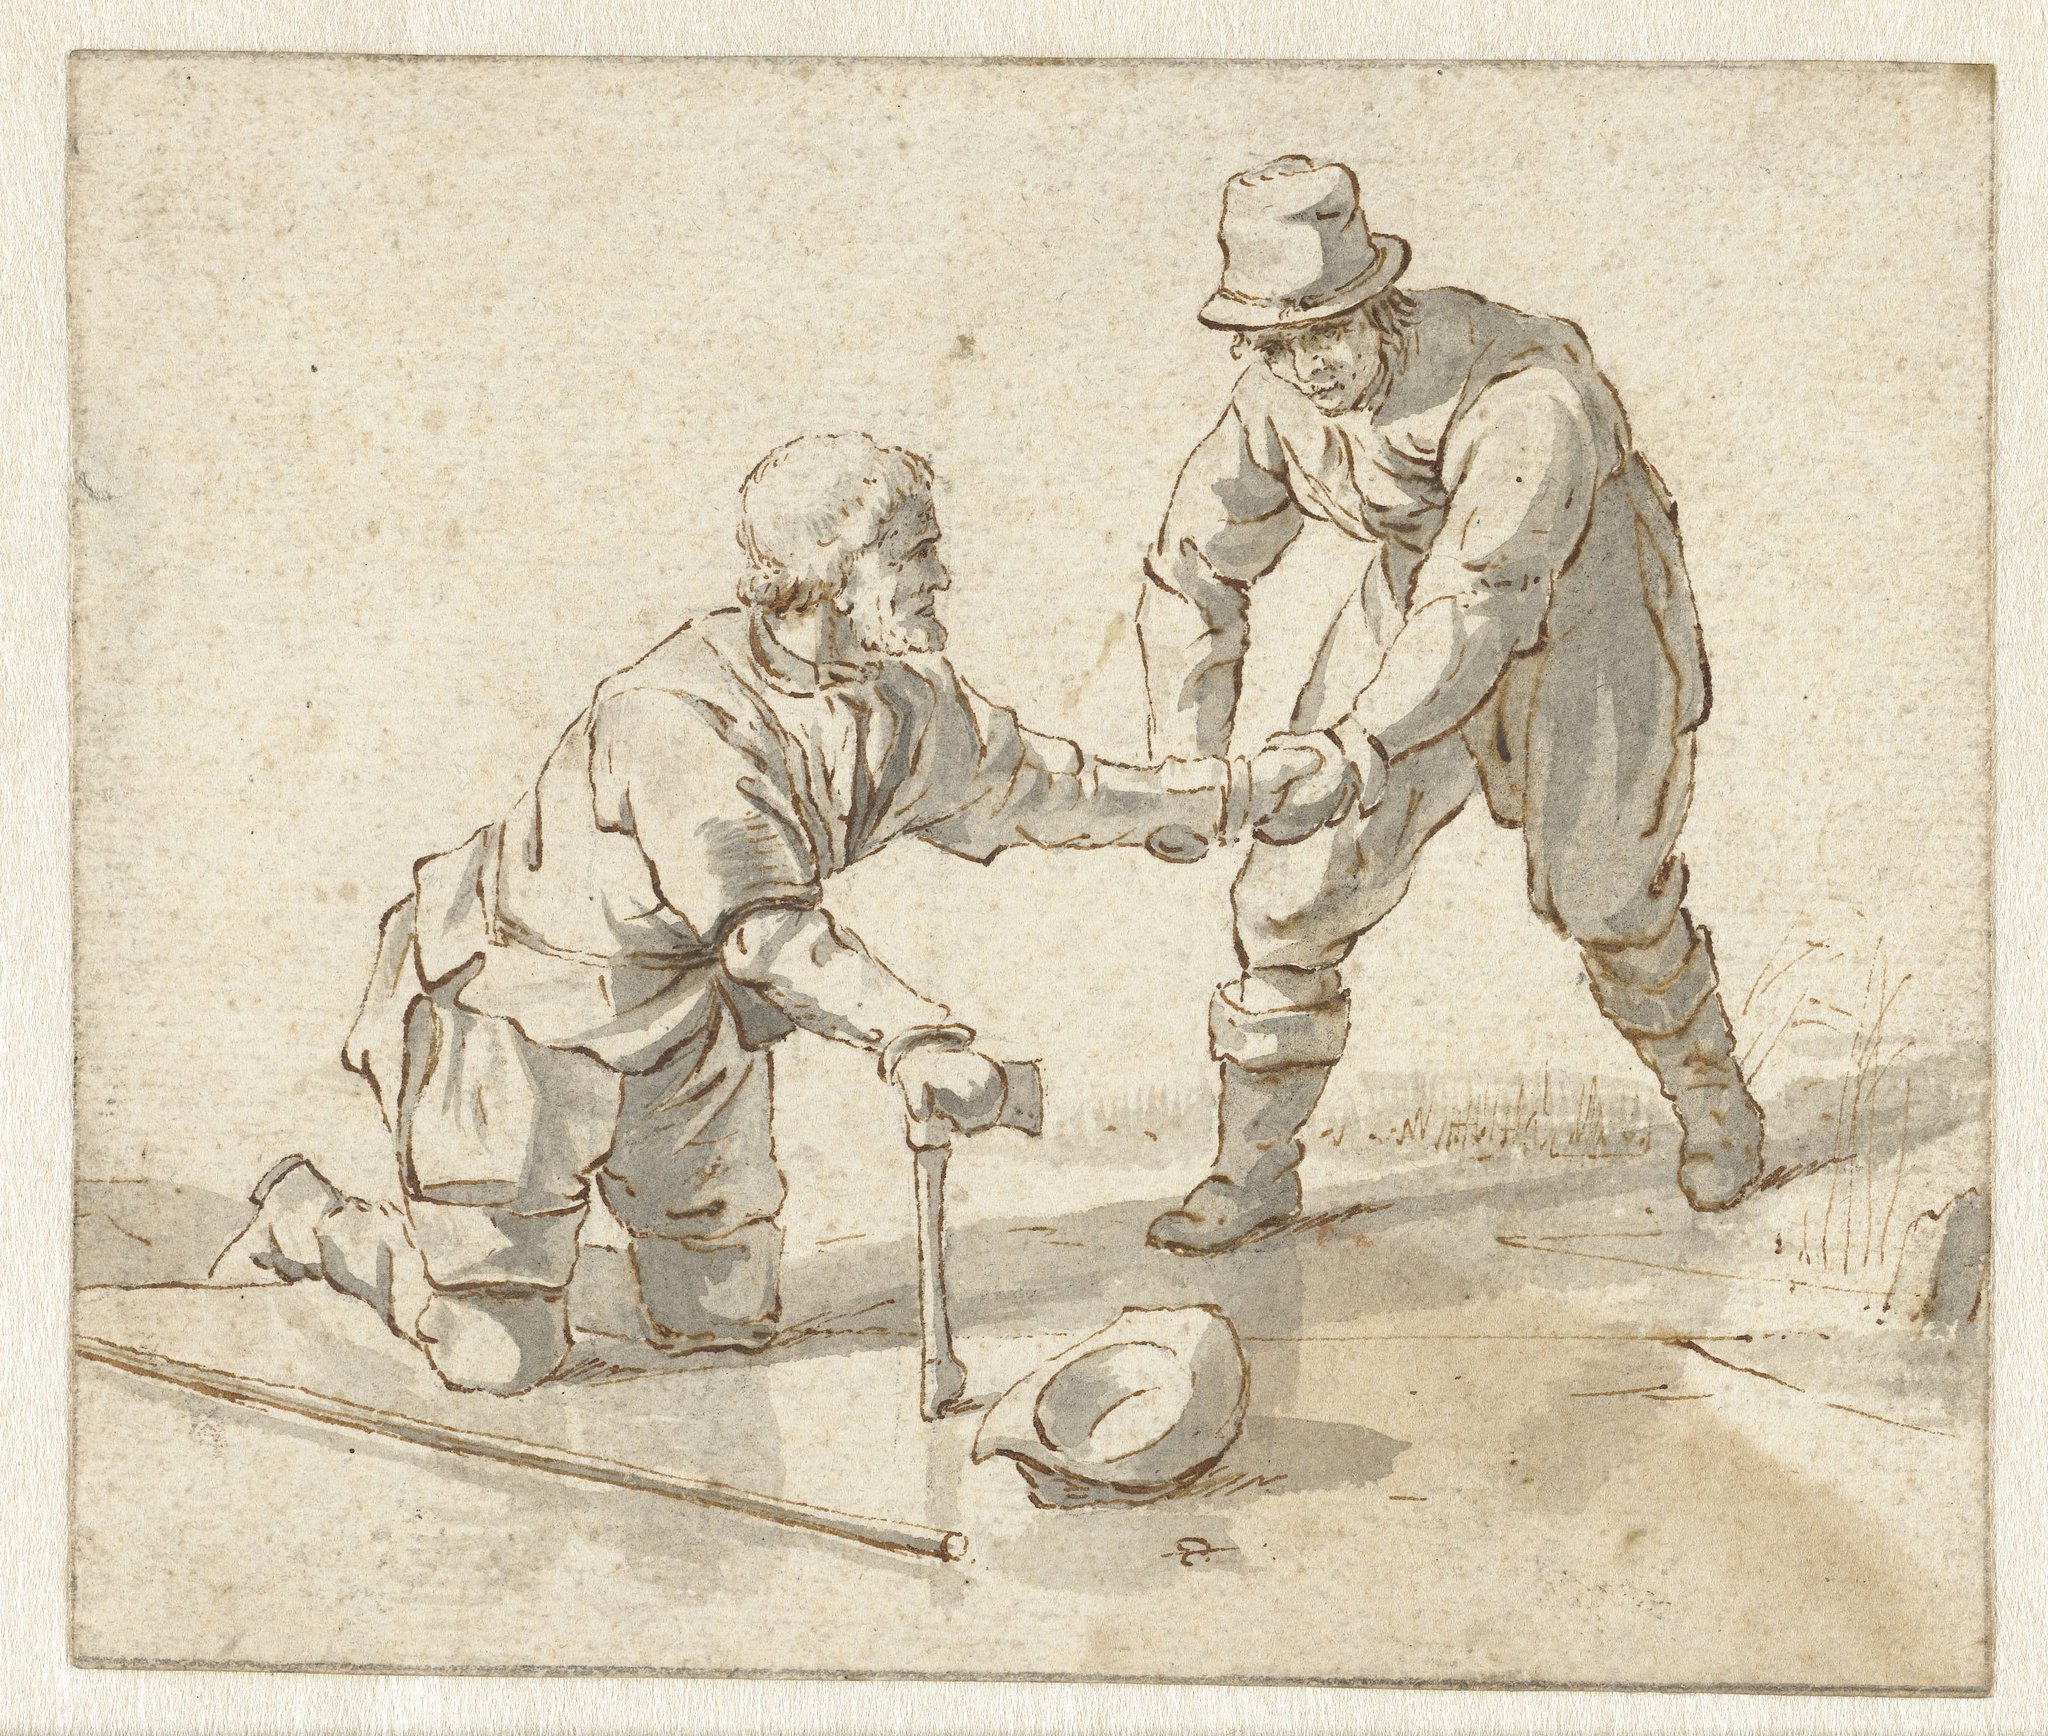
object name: drawing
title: Twee mannen op het ijs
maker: jacob cats (1741-1799)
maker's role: draughtsman, print maker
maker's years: 1741-1799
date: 1751-1799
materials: ink, paper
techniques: brush, pen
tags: going through the ice ~ playing children